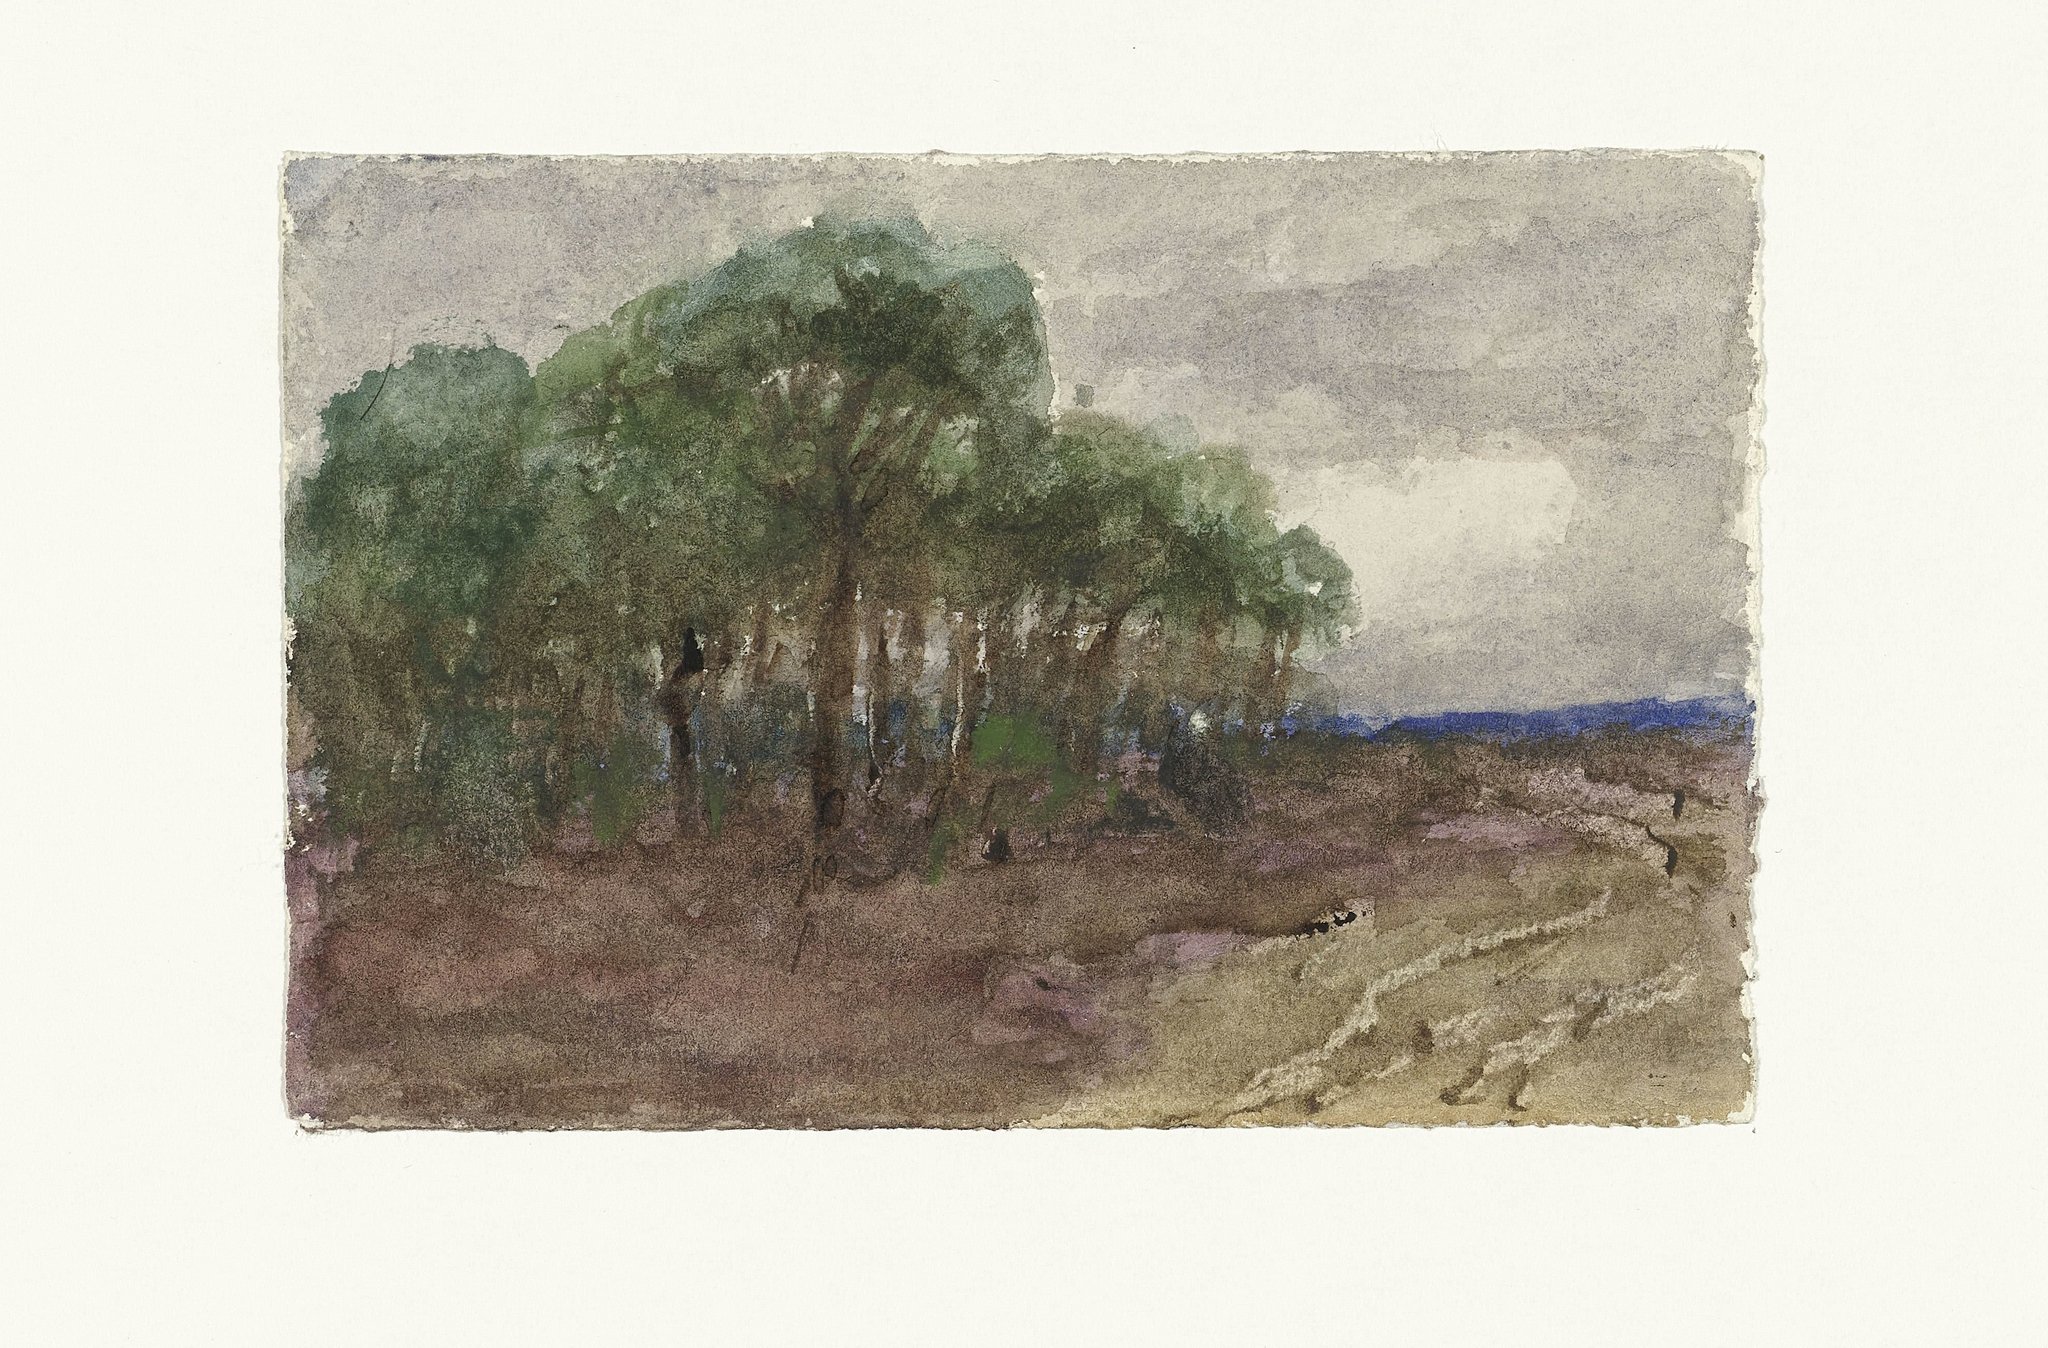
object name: postcard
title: Landschap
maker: sientje mesdag-van houten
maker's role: draughtsman, painter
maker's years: 1834-1909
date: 1844-1909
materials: paper, watercolor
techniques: aquarelle, brush